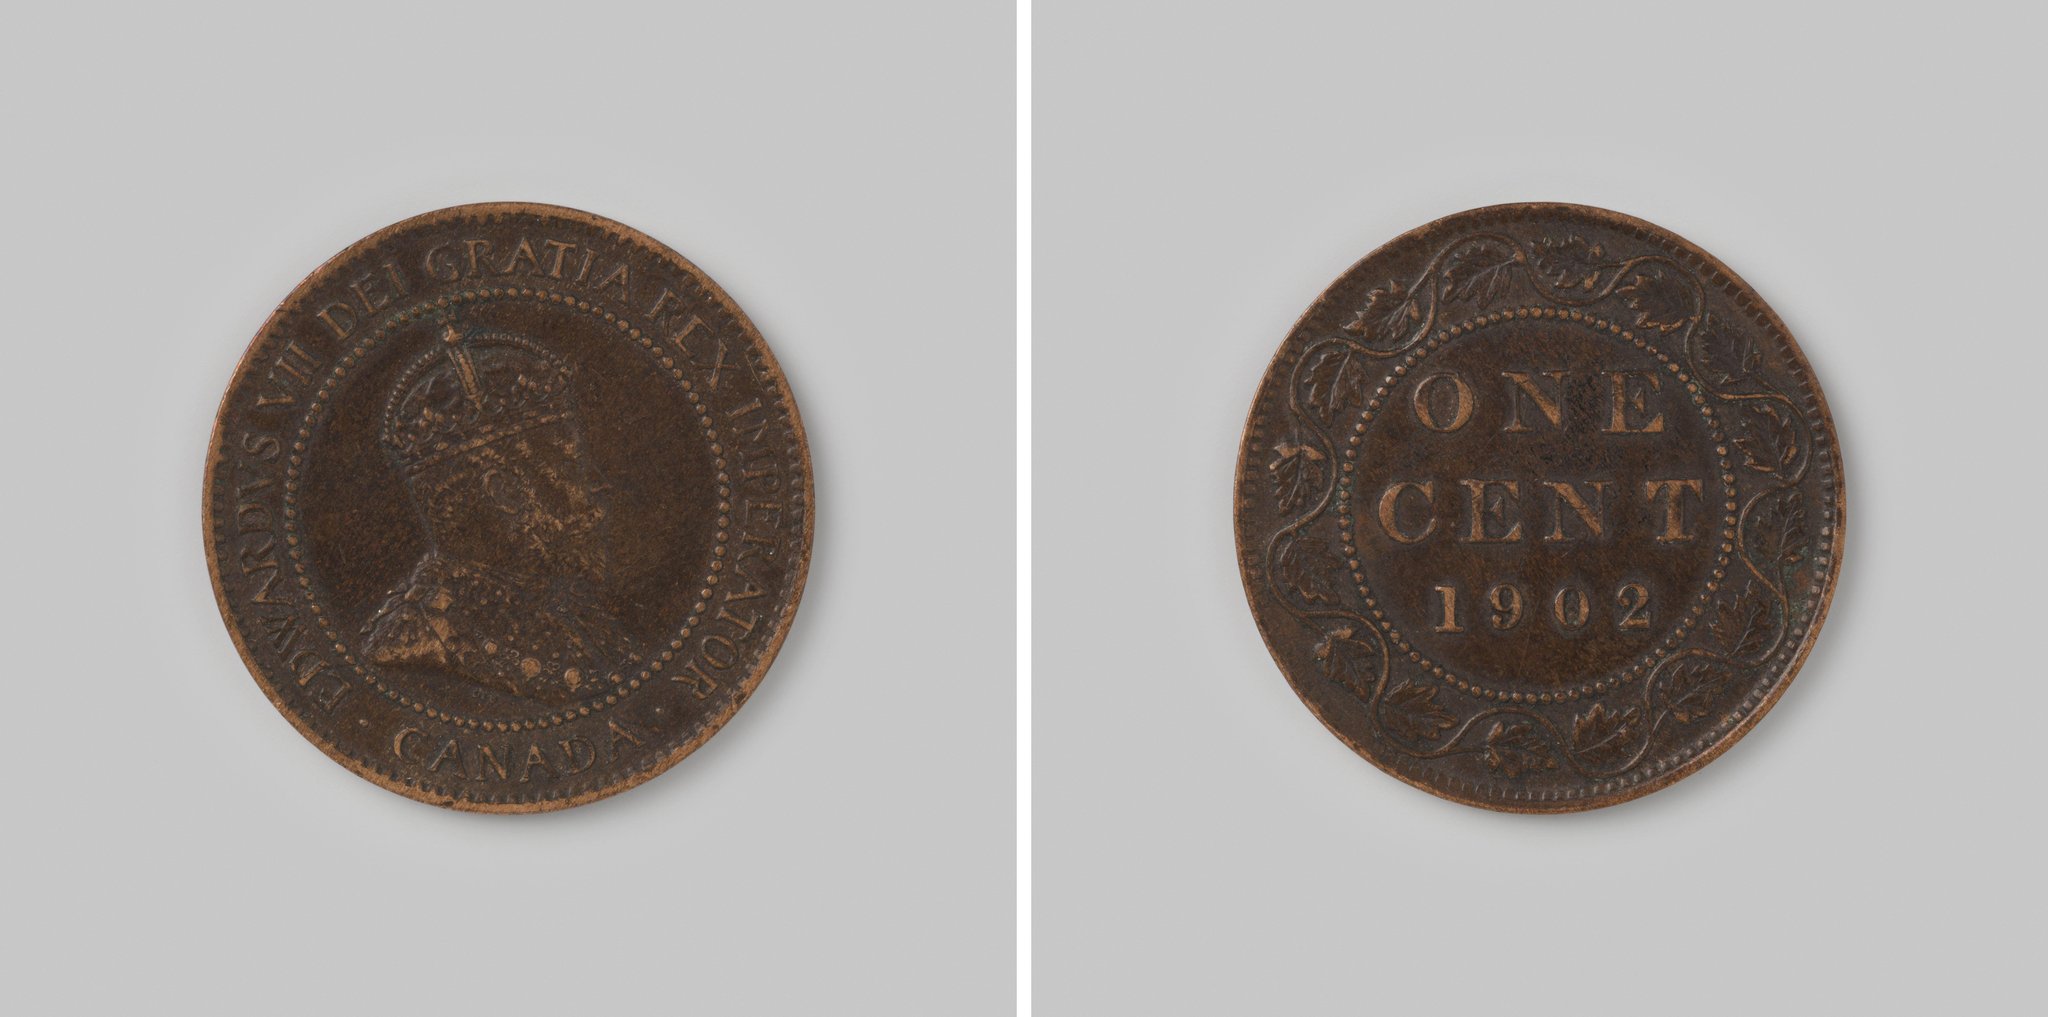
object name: coin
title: Canada, cent, 1902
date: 1902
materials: bronze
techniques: striking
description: Bronzen munt. Voorzijde: gekroond borstbeeld van Edward VII naar rechts. Daaronder lands-aanduiding. Keerzijde: binnen een kring van bladeren in twee regels waarde-aanduiding, waaronder jaartal. Gladde rand.